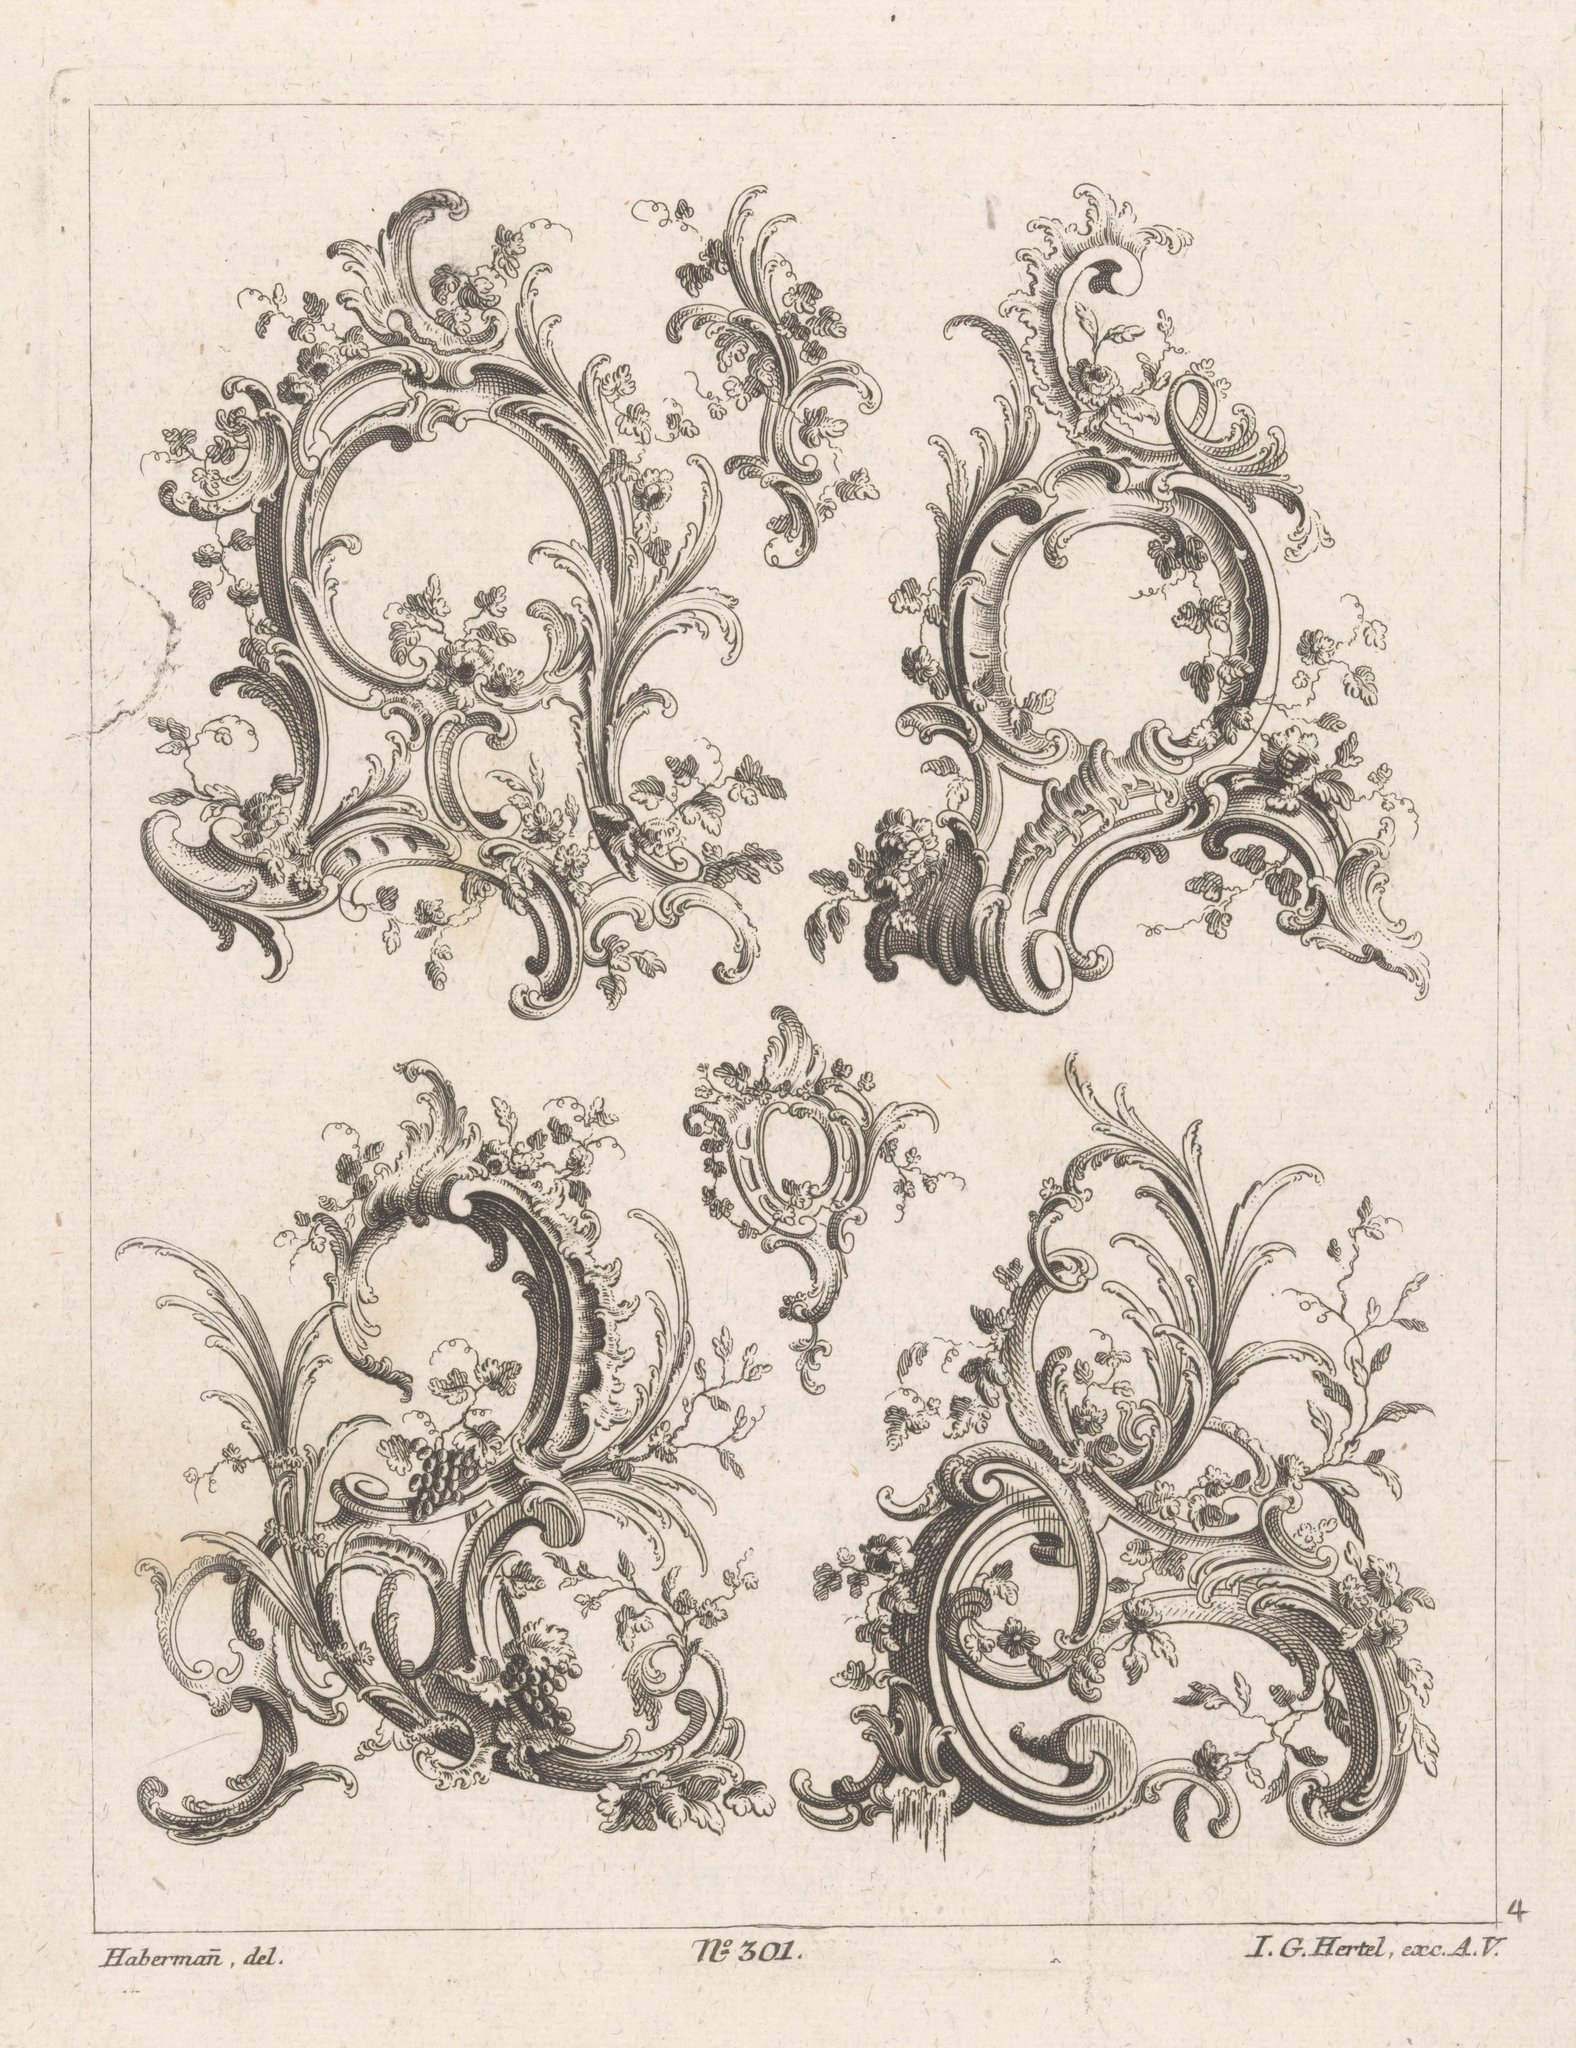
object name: print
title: Rocailles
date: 1731-1775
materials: paper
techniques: etching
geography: augsburg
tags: rocaille ornament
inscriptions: collector's mark: Lugt 2228, collector's mark: Lugt 2760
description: Zes rocaille ornamenten met bladmotieven en druivenranken. Uitgeversnummer 301.